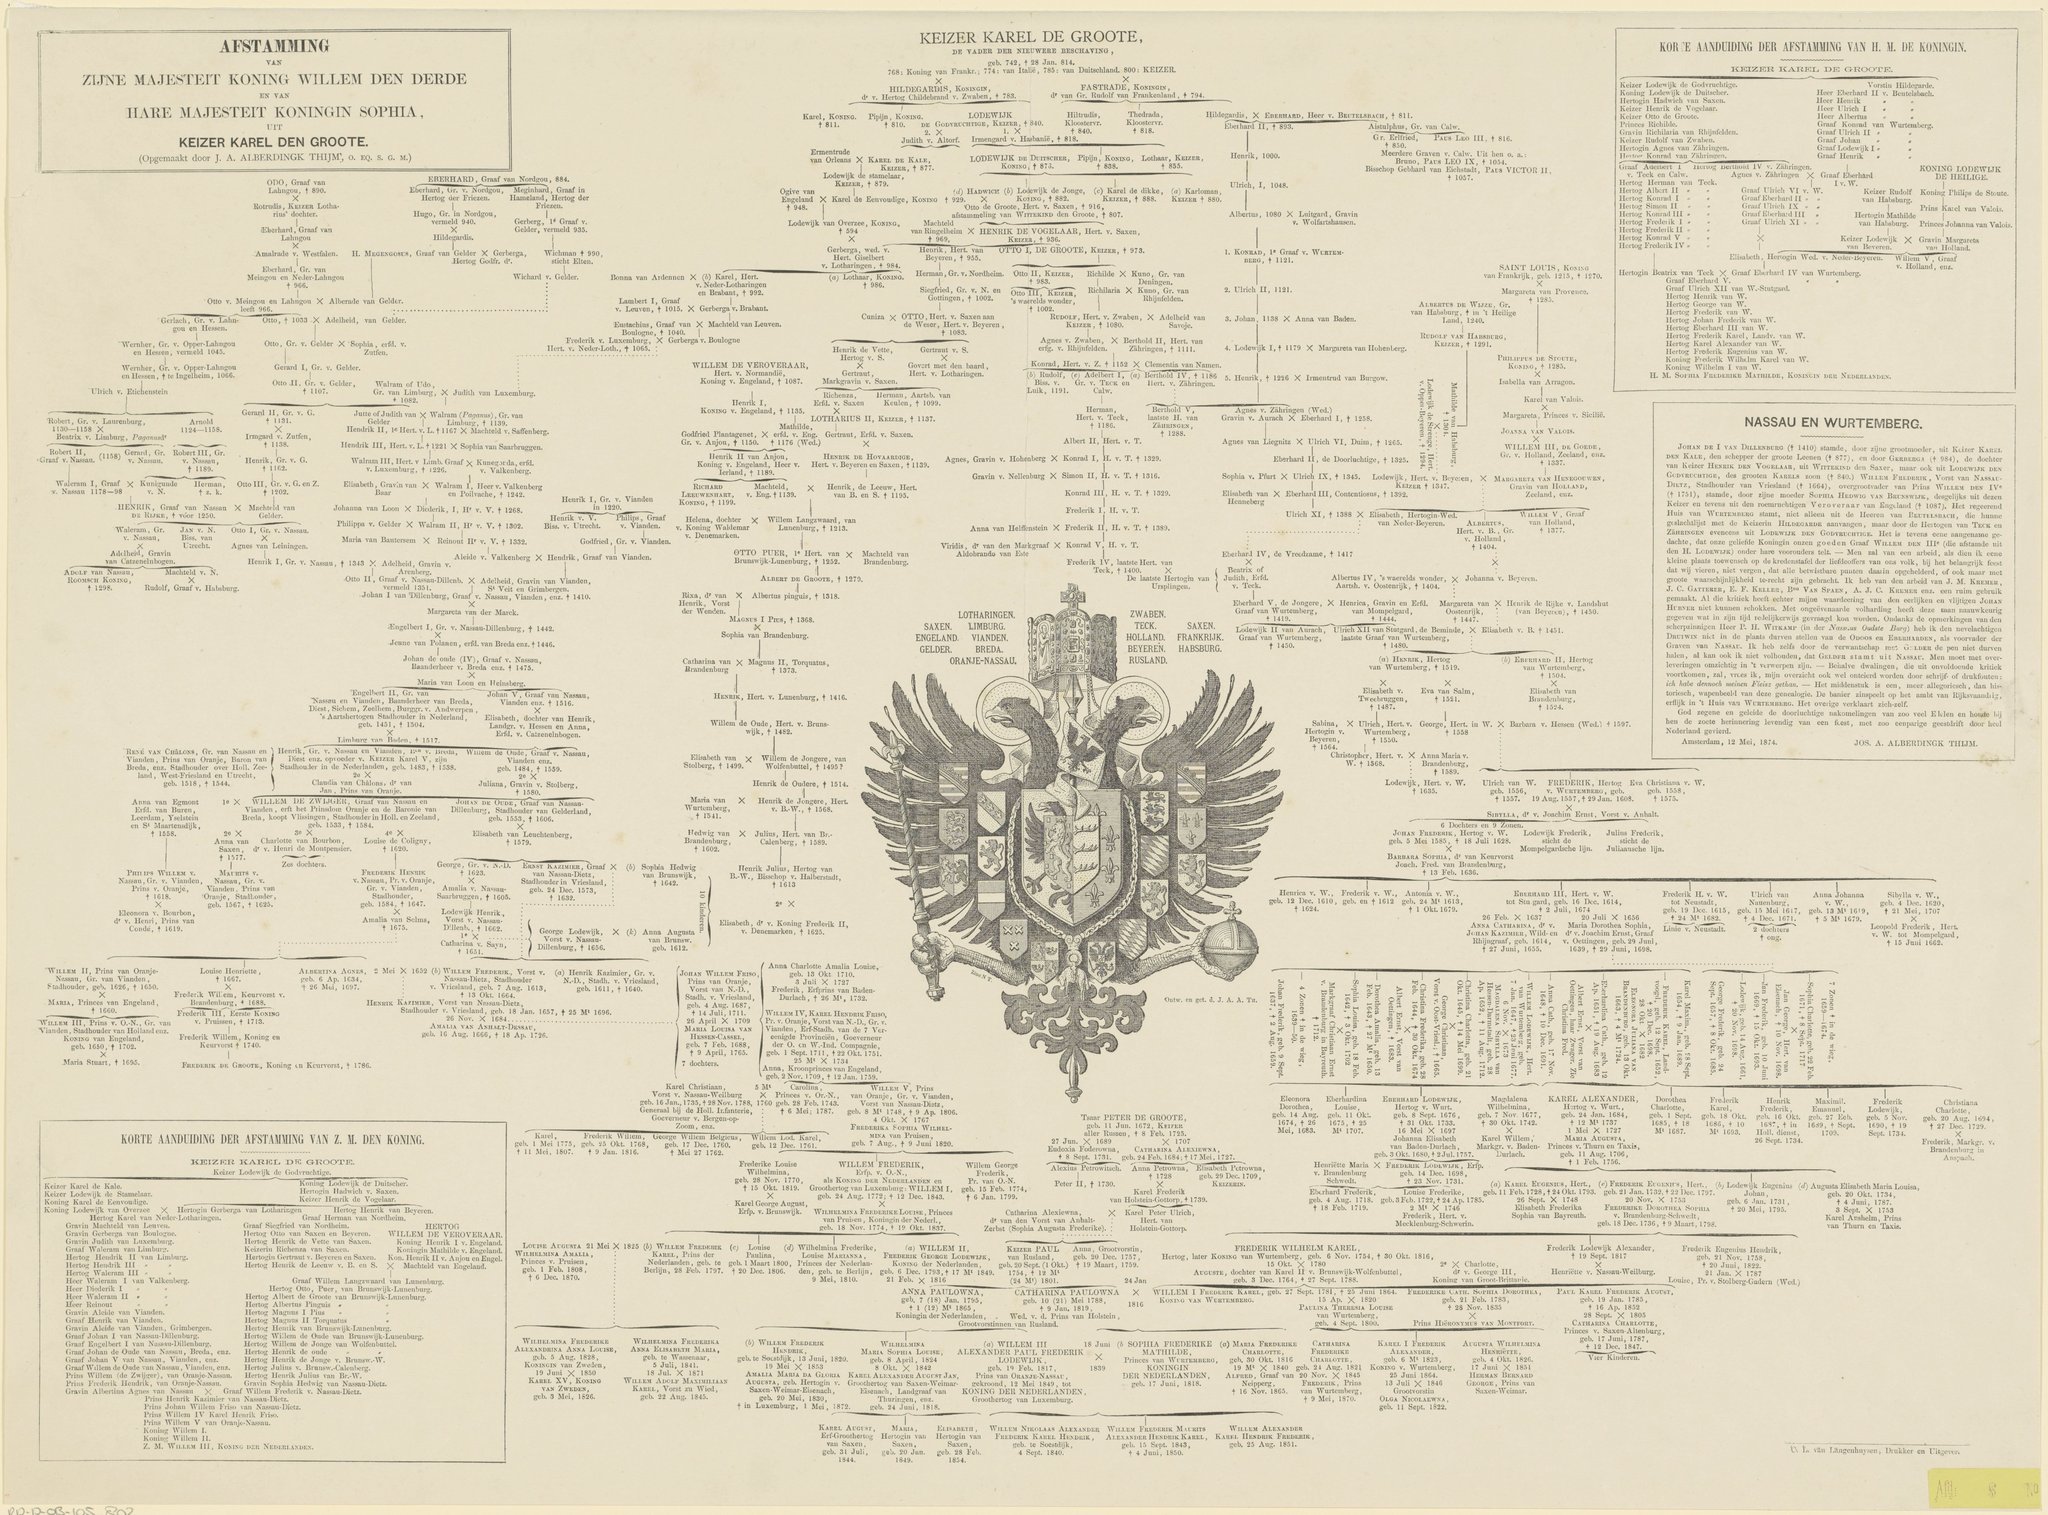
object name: print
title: Stamboom van Willem III, koning der Nederlanden, en Sophie van Württemberg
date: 1874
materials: paper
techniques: letterpress printing, engraving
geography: amsterdam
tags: brussels, willem iii (koning der nederlanden), the hague, sophia frederika mathilda van württemberg, charlemagne (holy roman emperor), family lineage, pedigree, genealogical tree or table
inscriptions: date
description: Stamboom van Willem III en Sophie, van Karel de Grote tot en met 1874. In het midden meerdere wapens en een tweekoppige adelaar met een kroon, een scepter en de rijksappel. Daar omheen namen, titels, geboortedata, trouwdata en sterfdata in boekdruk.